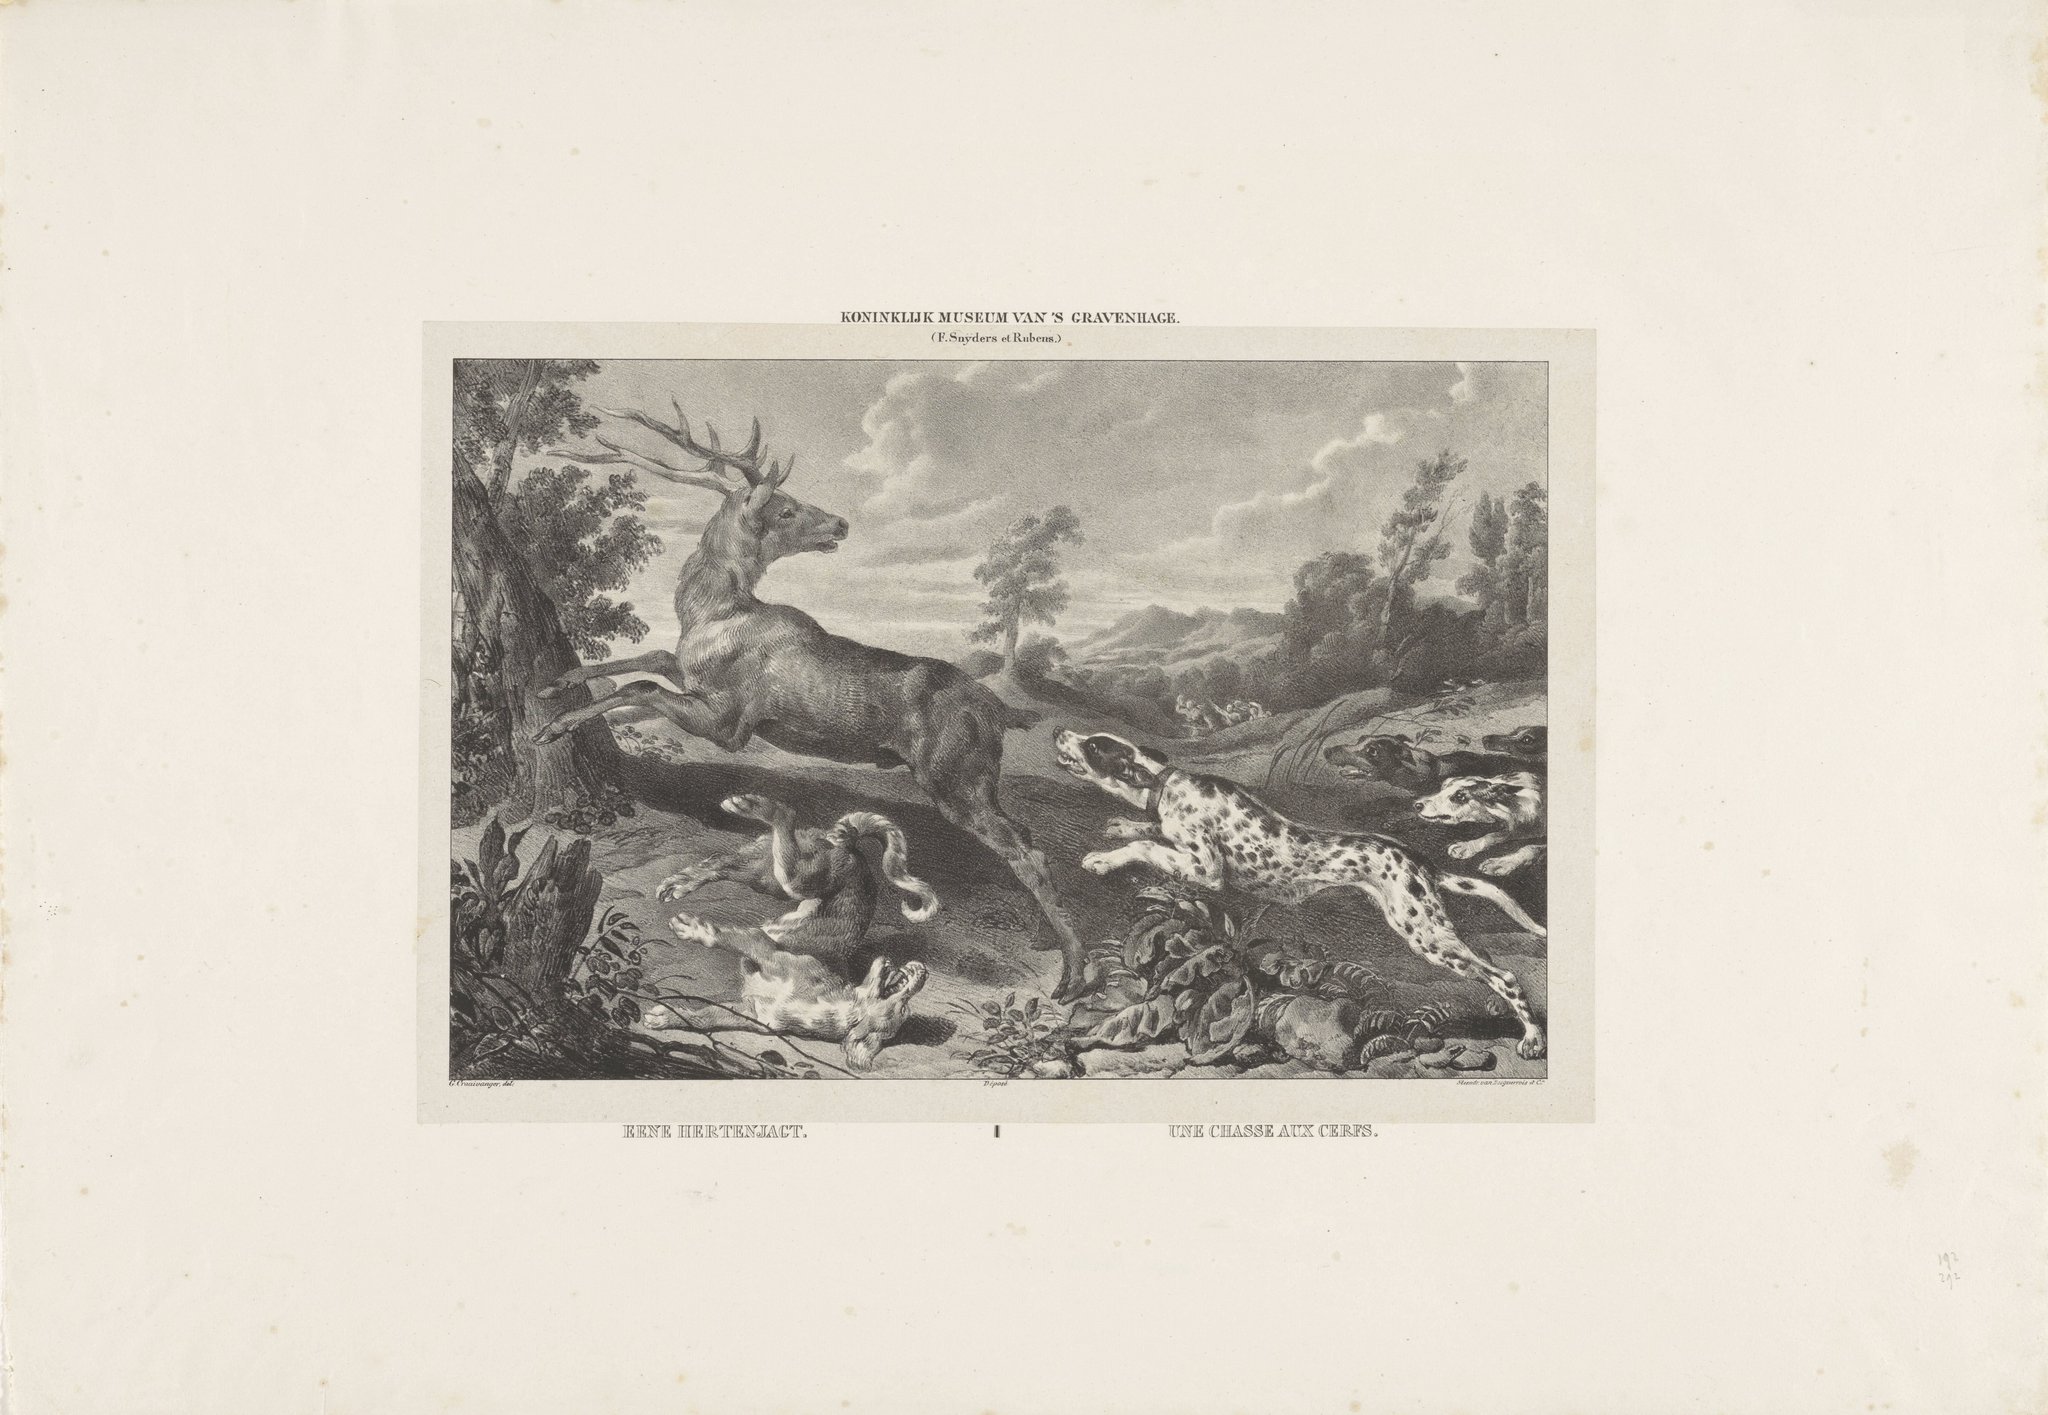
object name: print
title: Eene hertenjagt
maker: gijsbertus craeyvanger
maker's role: draughtsman, print maker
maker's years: 1810-1895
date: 1833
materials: paper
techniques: lithograph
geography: netherlands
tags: stag-hunting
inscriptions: : ‘Déposé’, collector's mark: Lugt 2228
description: Een hert wordt op de hielen gezeten door een groep honden. Een hond rolt over de grond terwijl een andere vlakbij komt. Verderop in het landschap rennen de jagers. Deze prent werd gemaakt naar een schilderij van Paul de Vos en Jan Wildens in het Mauritshuis in Den Haag.